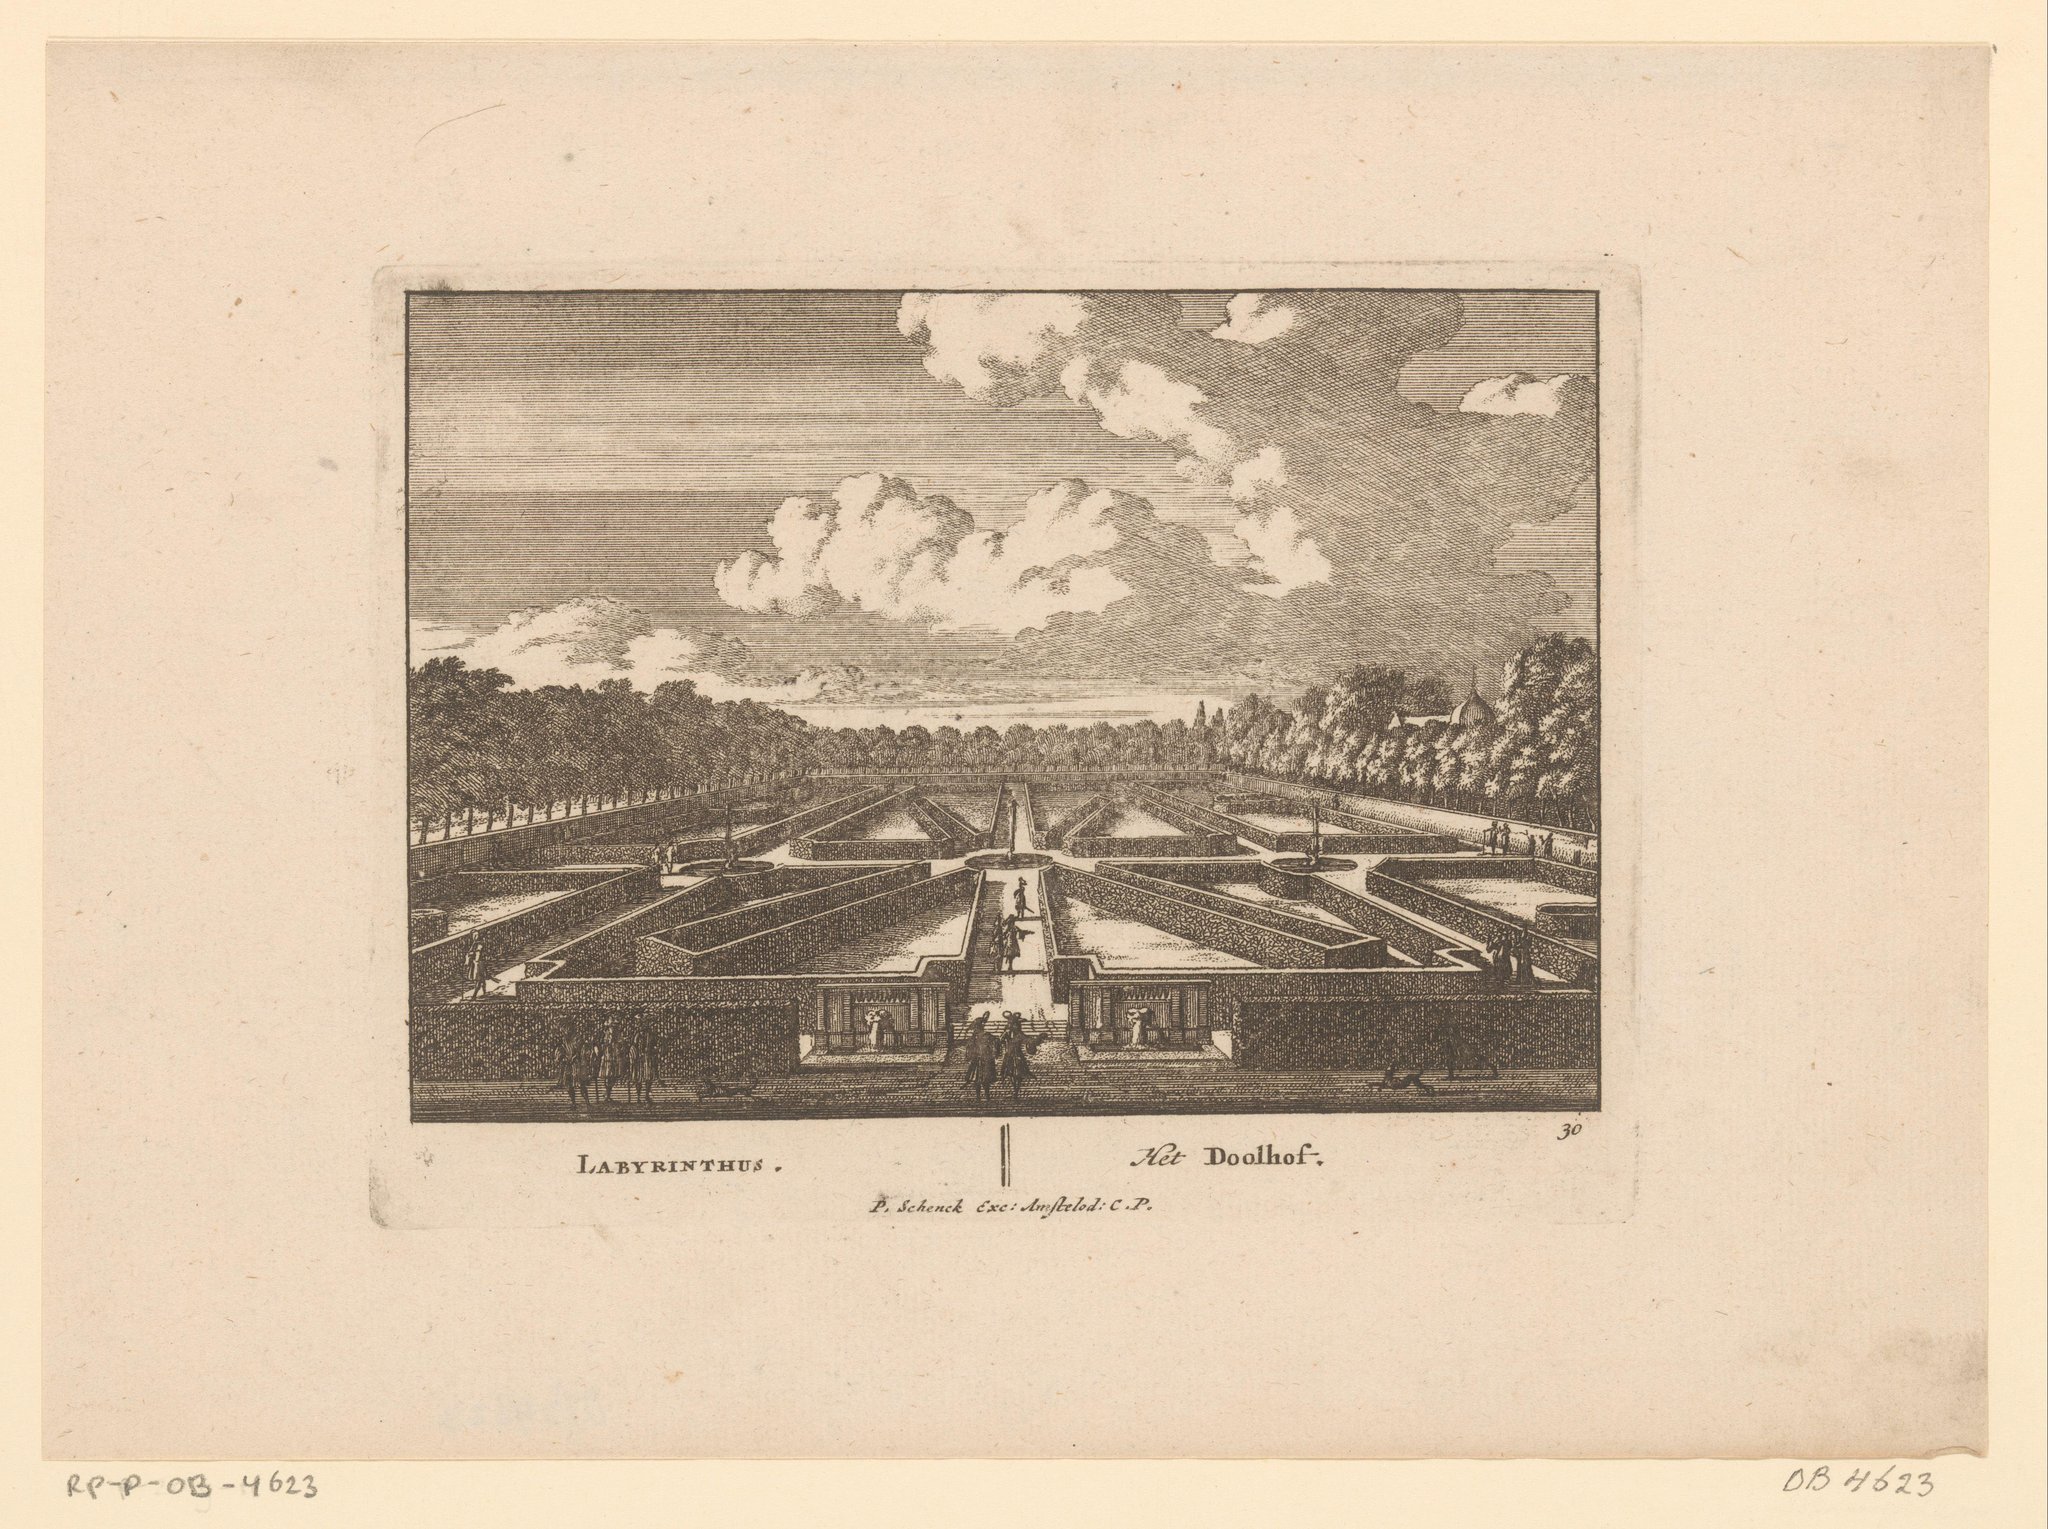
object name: print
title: Doolhof bij Paleis Het Loo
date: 1700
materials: paper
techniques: etching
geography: amsterdam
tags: garden, labyrinth, maze ~ garden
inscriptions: collector's mark: Lugt 2228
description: Andere staat ook gebruikt in: Call, Jan van. Admirandorum Quadruplex Spectaculum. Amsterdam: Pieter Schenk (I), [1700].* * De titelprent, opdracht en het portret van Frederik van Saksen zijn gegraveerd door Pieter Schenk (I). De overige prenten uit deze serie zijn, zoals aangegeven op de titelprent, van de hand van Jan van Call (I).